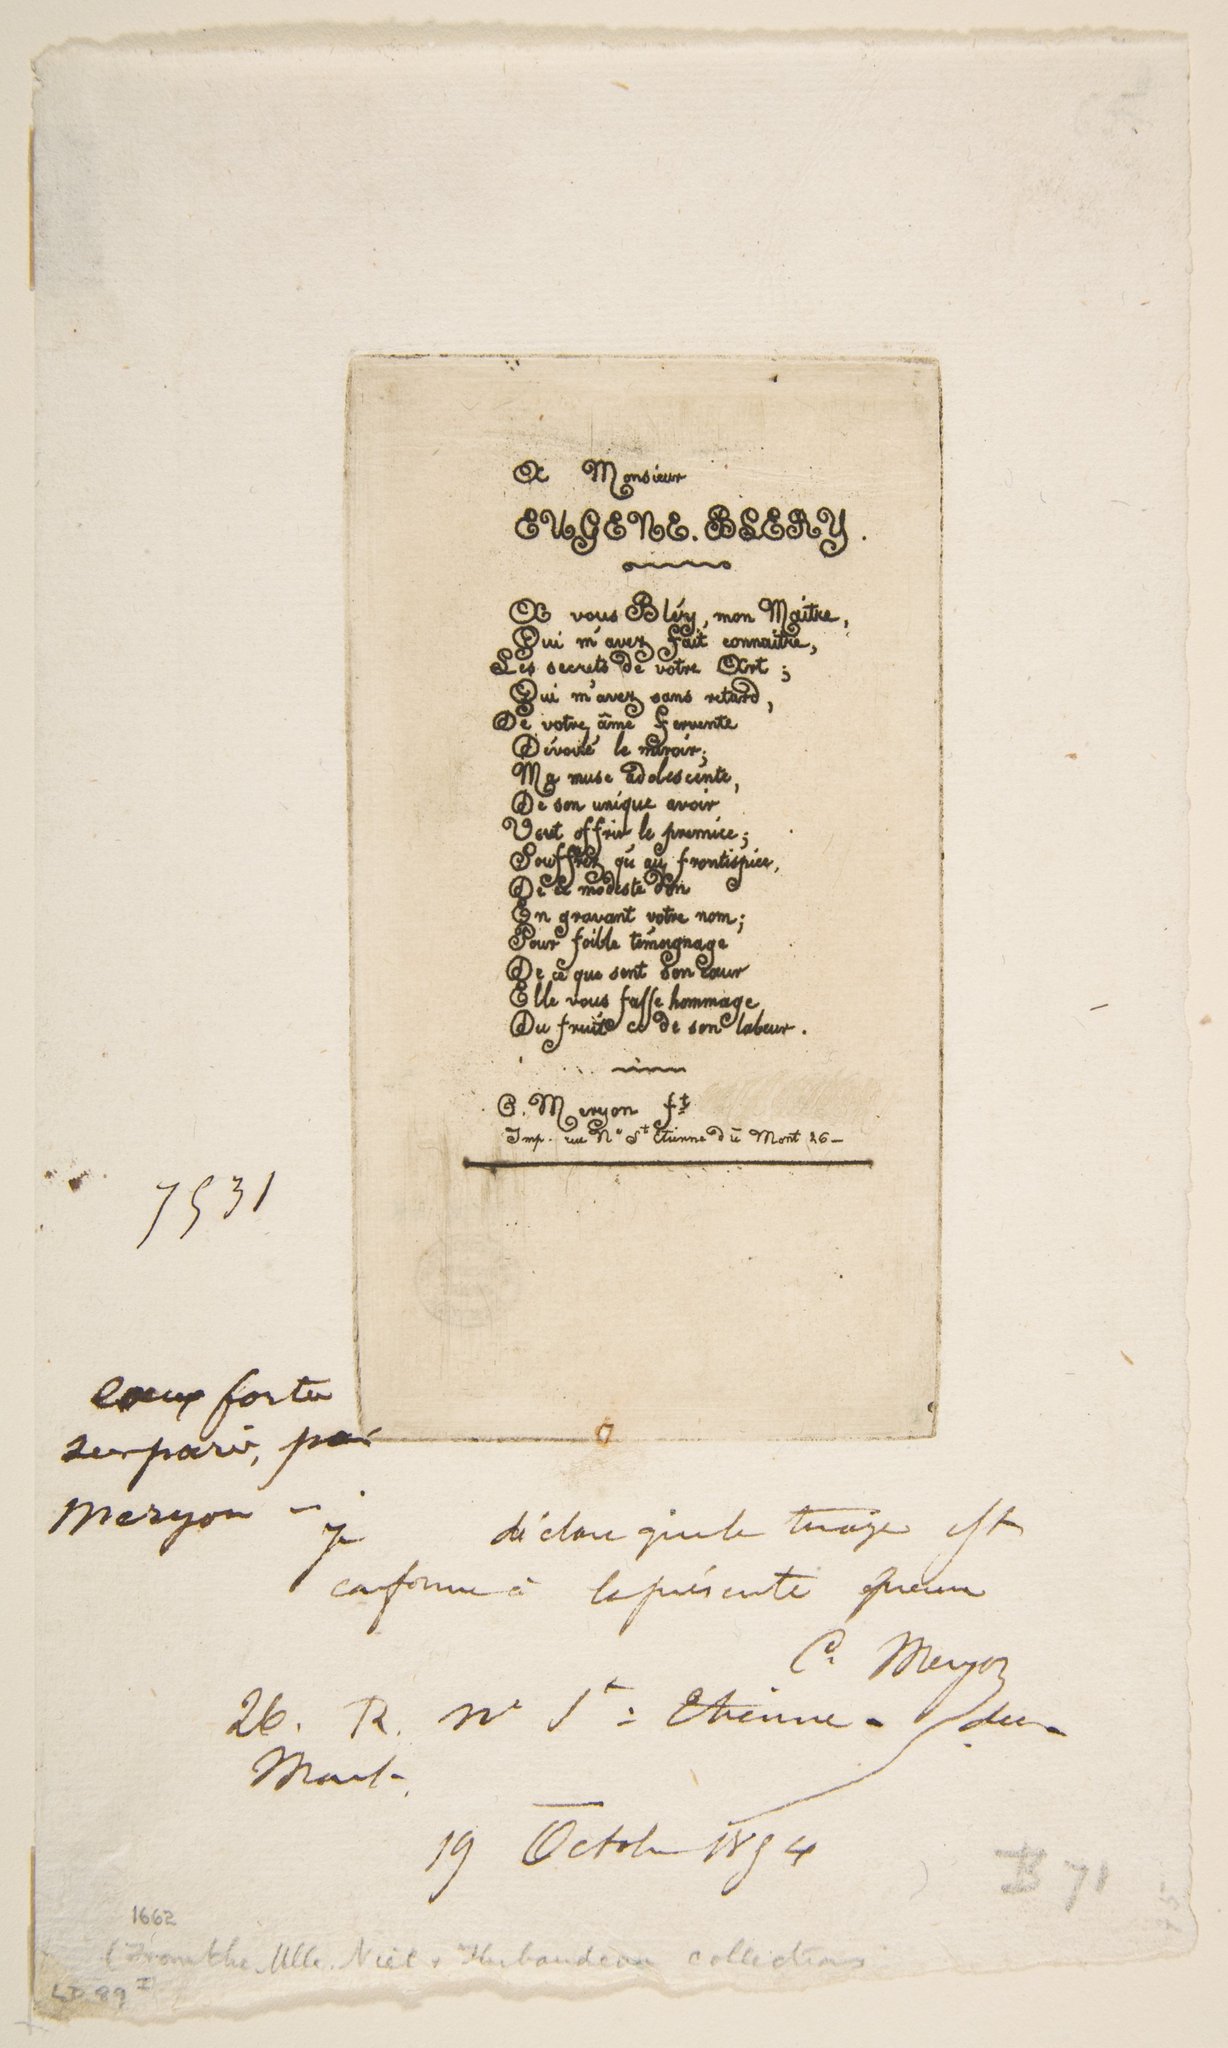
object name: print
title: Vers a Eugène Bléry, No 2 (Verses dedicated to Eugène Bléry, No 2)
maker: charles meryon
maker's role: artist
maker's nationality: french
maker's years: 1821-1868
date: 1854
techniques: etching